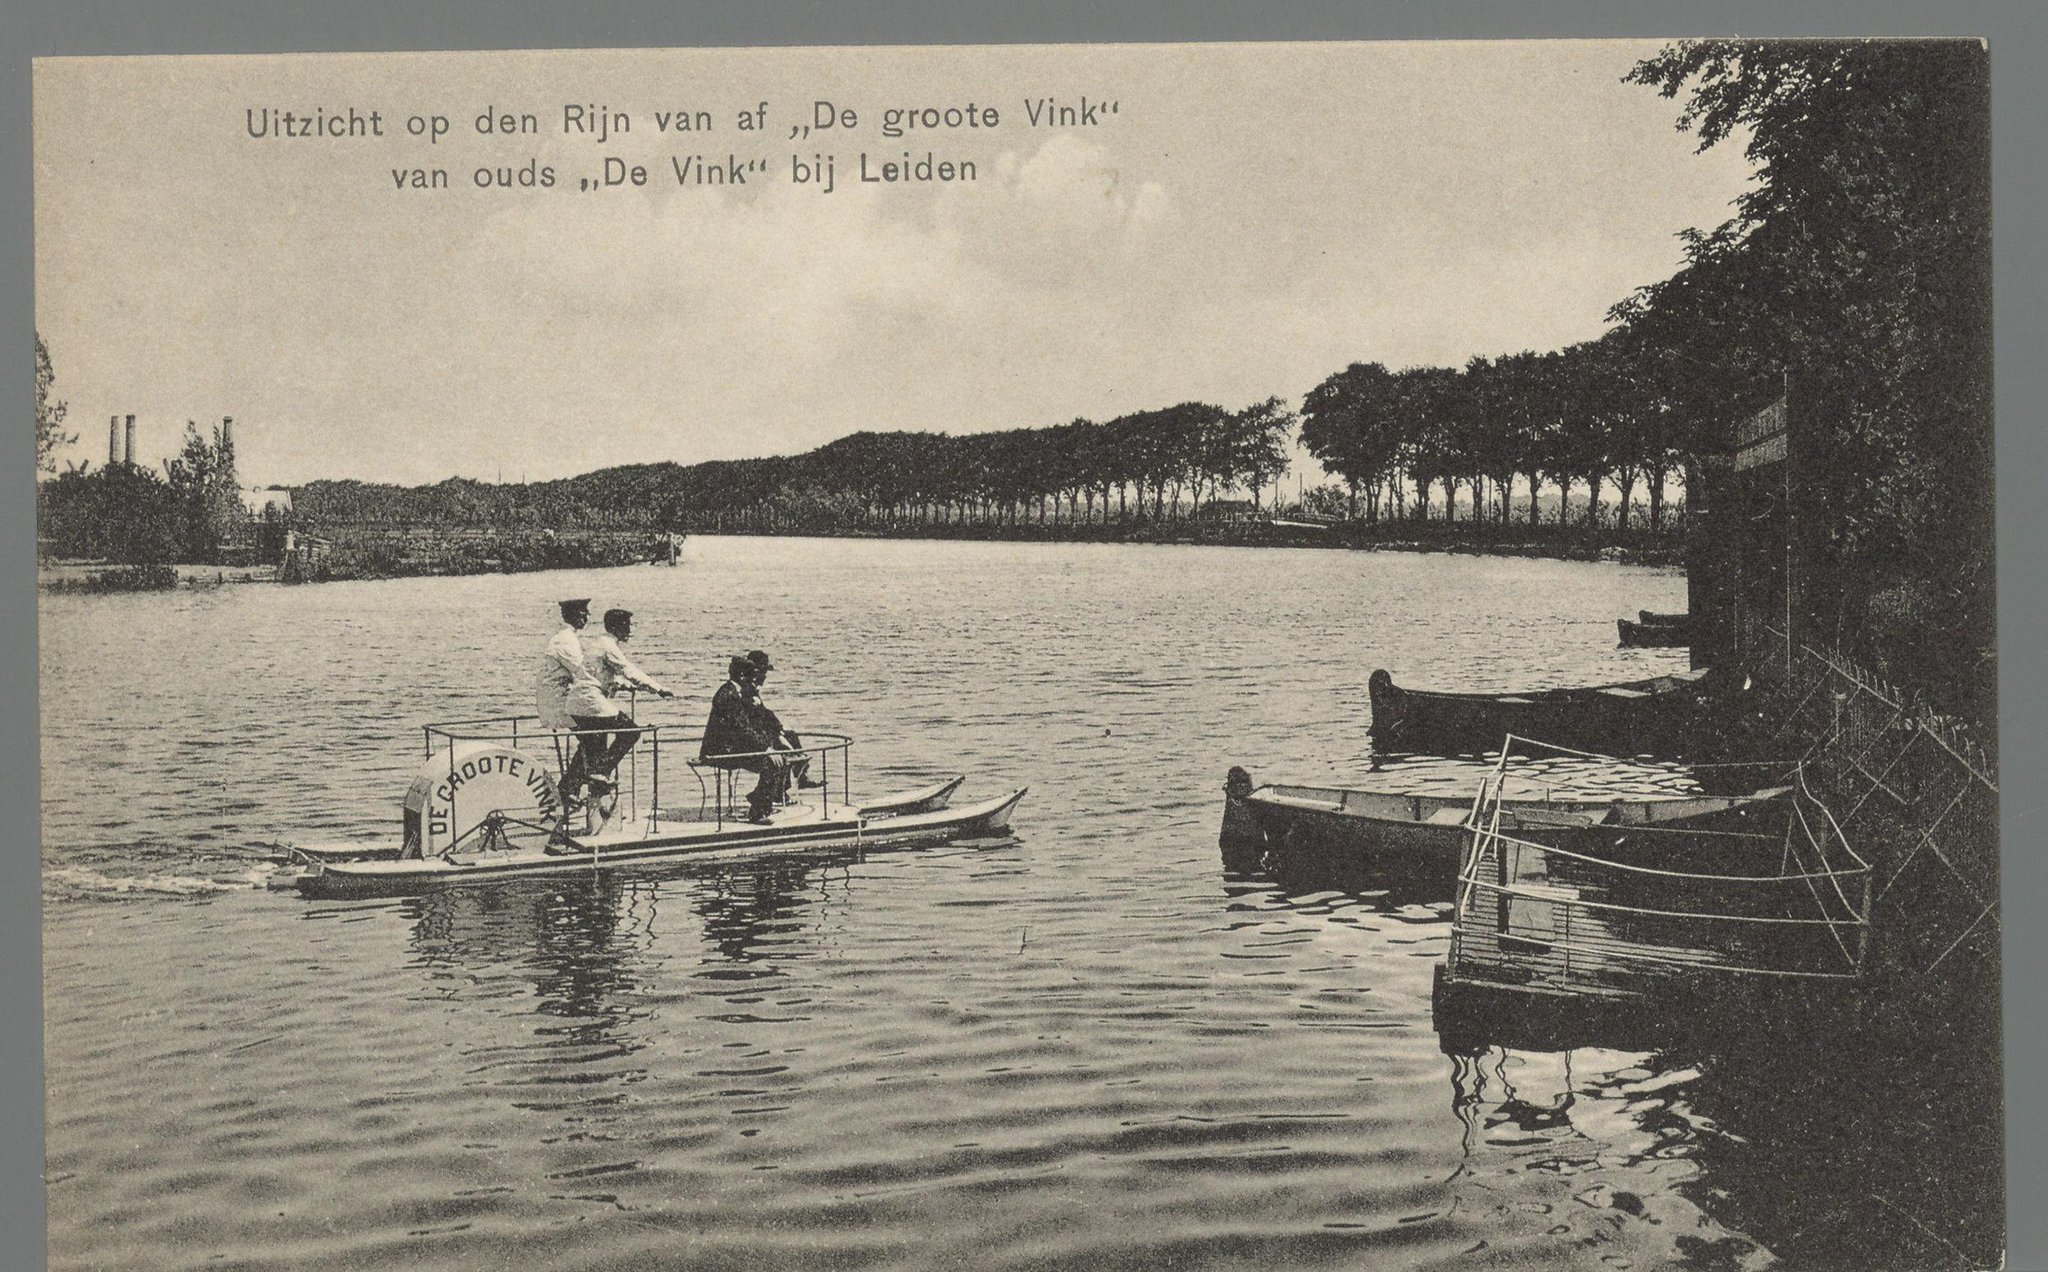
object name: ansichtkaart, prentbriefkaart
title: Uitzicht op den Rijn van af "De groote Vink". Van ouds "de Vink" bij Leiden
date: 1909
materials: cardboard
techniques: photograph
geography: leiden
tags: river, leiden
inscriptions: date